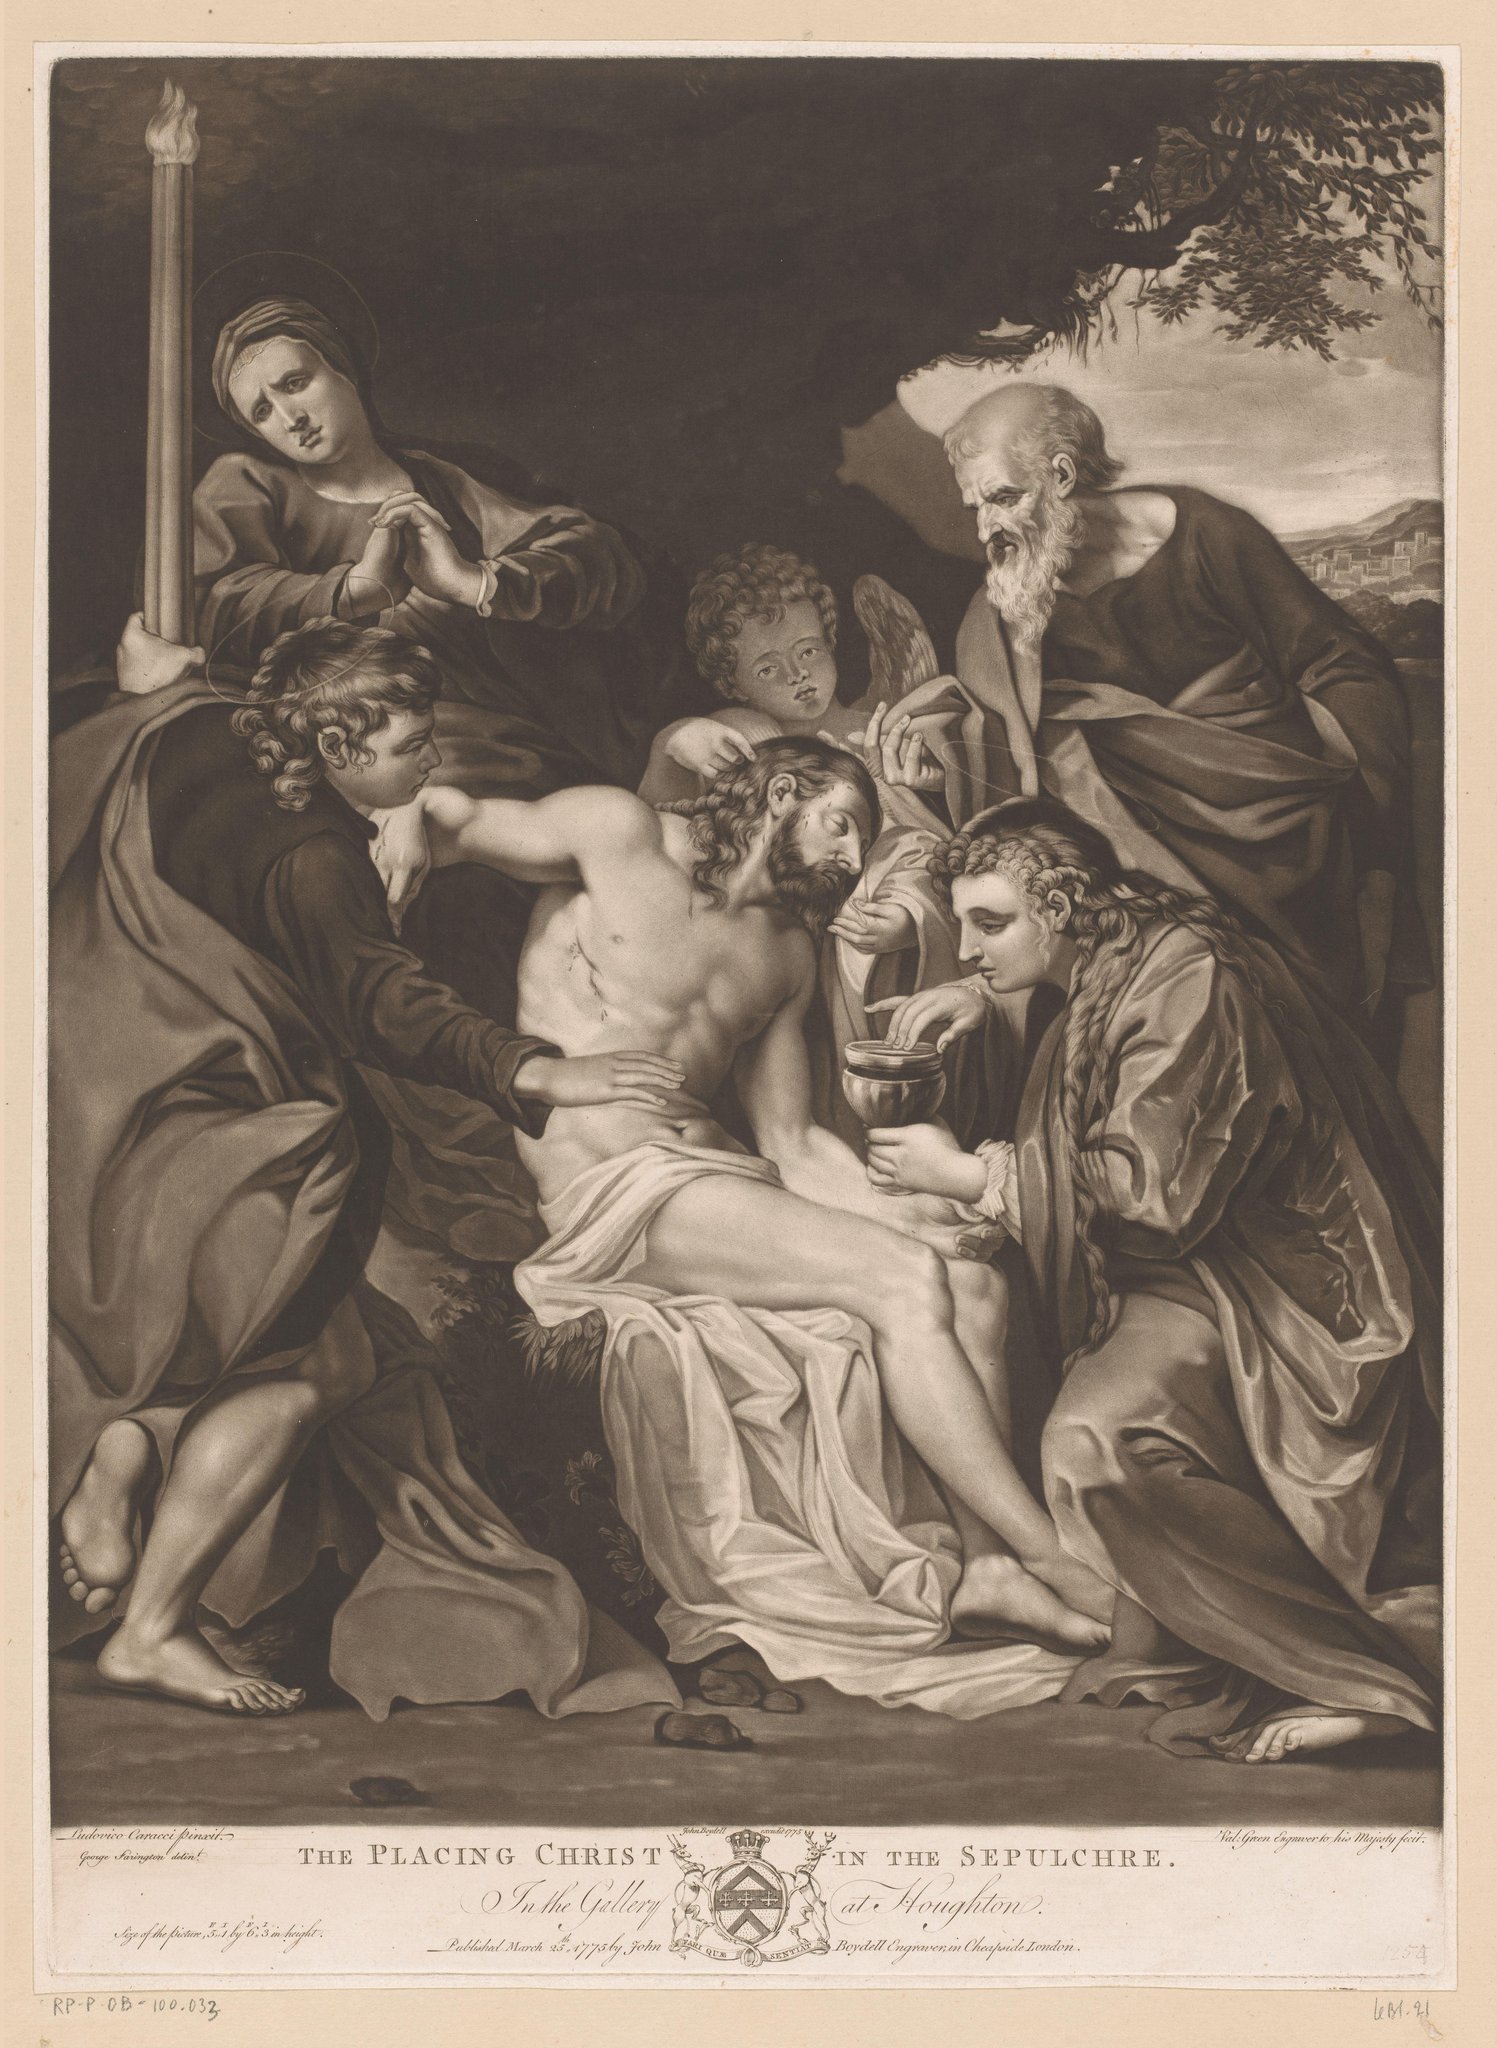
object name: print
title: The placing Christ in the Sepulchre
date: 1775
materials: paper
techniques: etching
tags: christ's entombment (possibly by angels)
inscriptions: collector's mark: Lugt 240